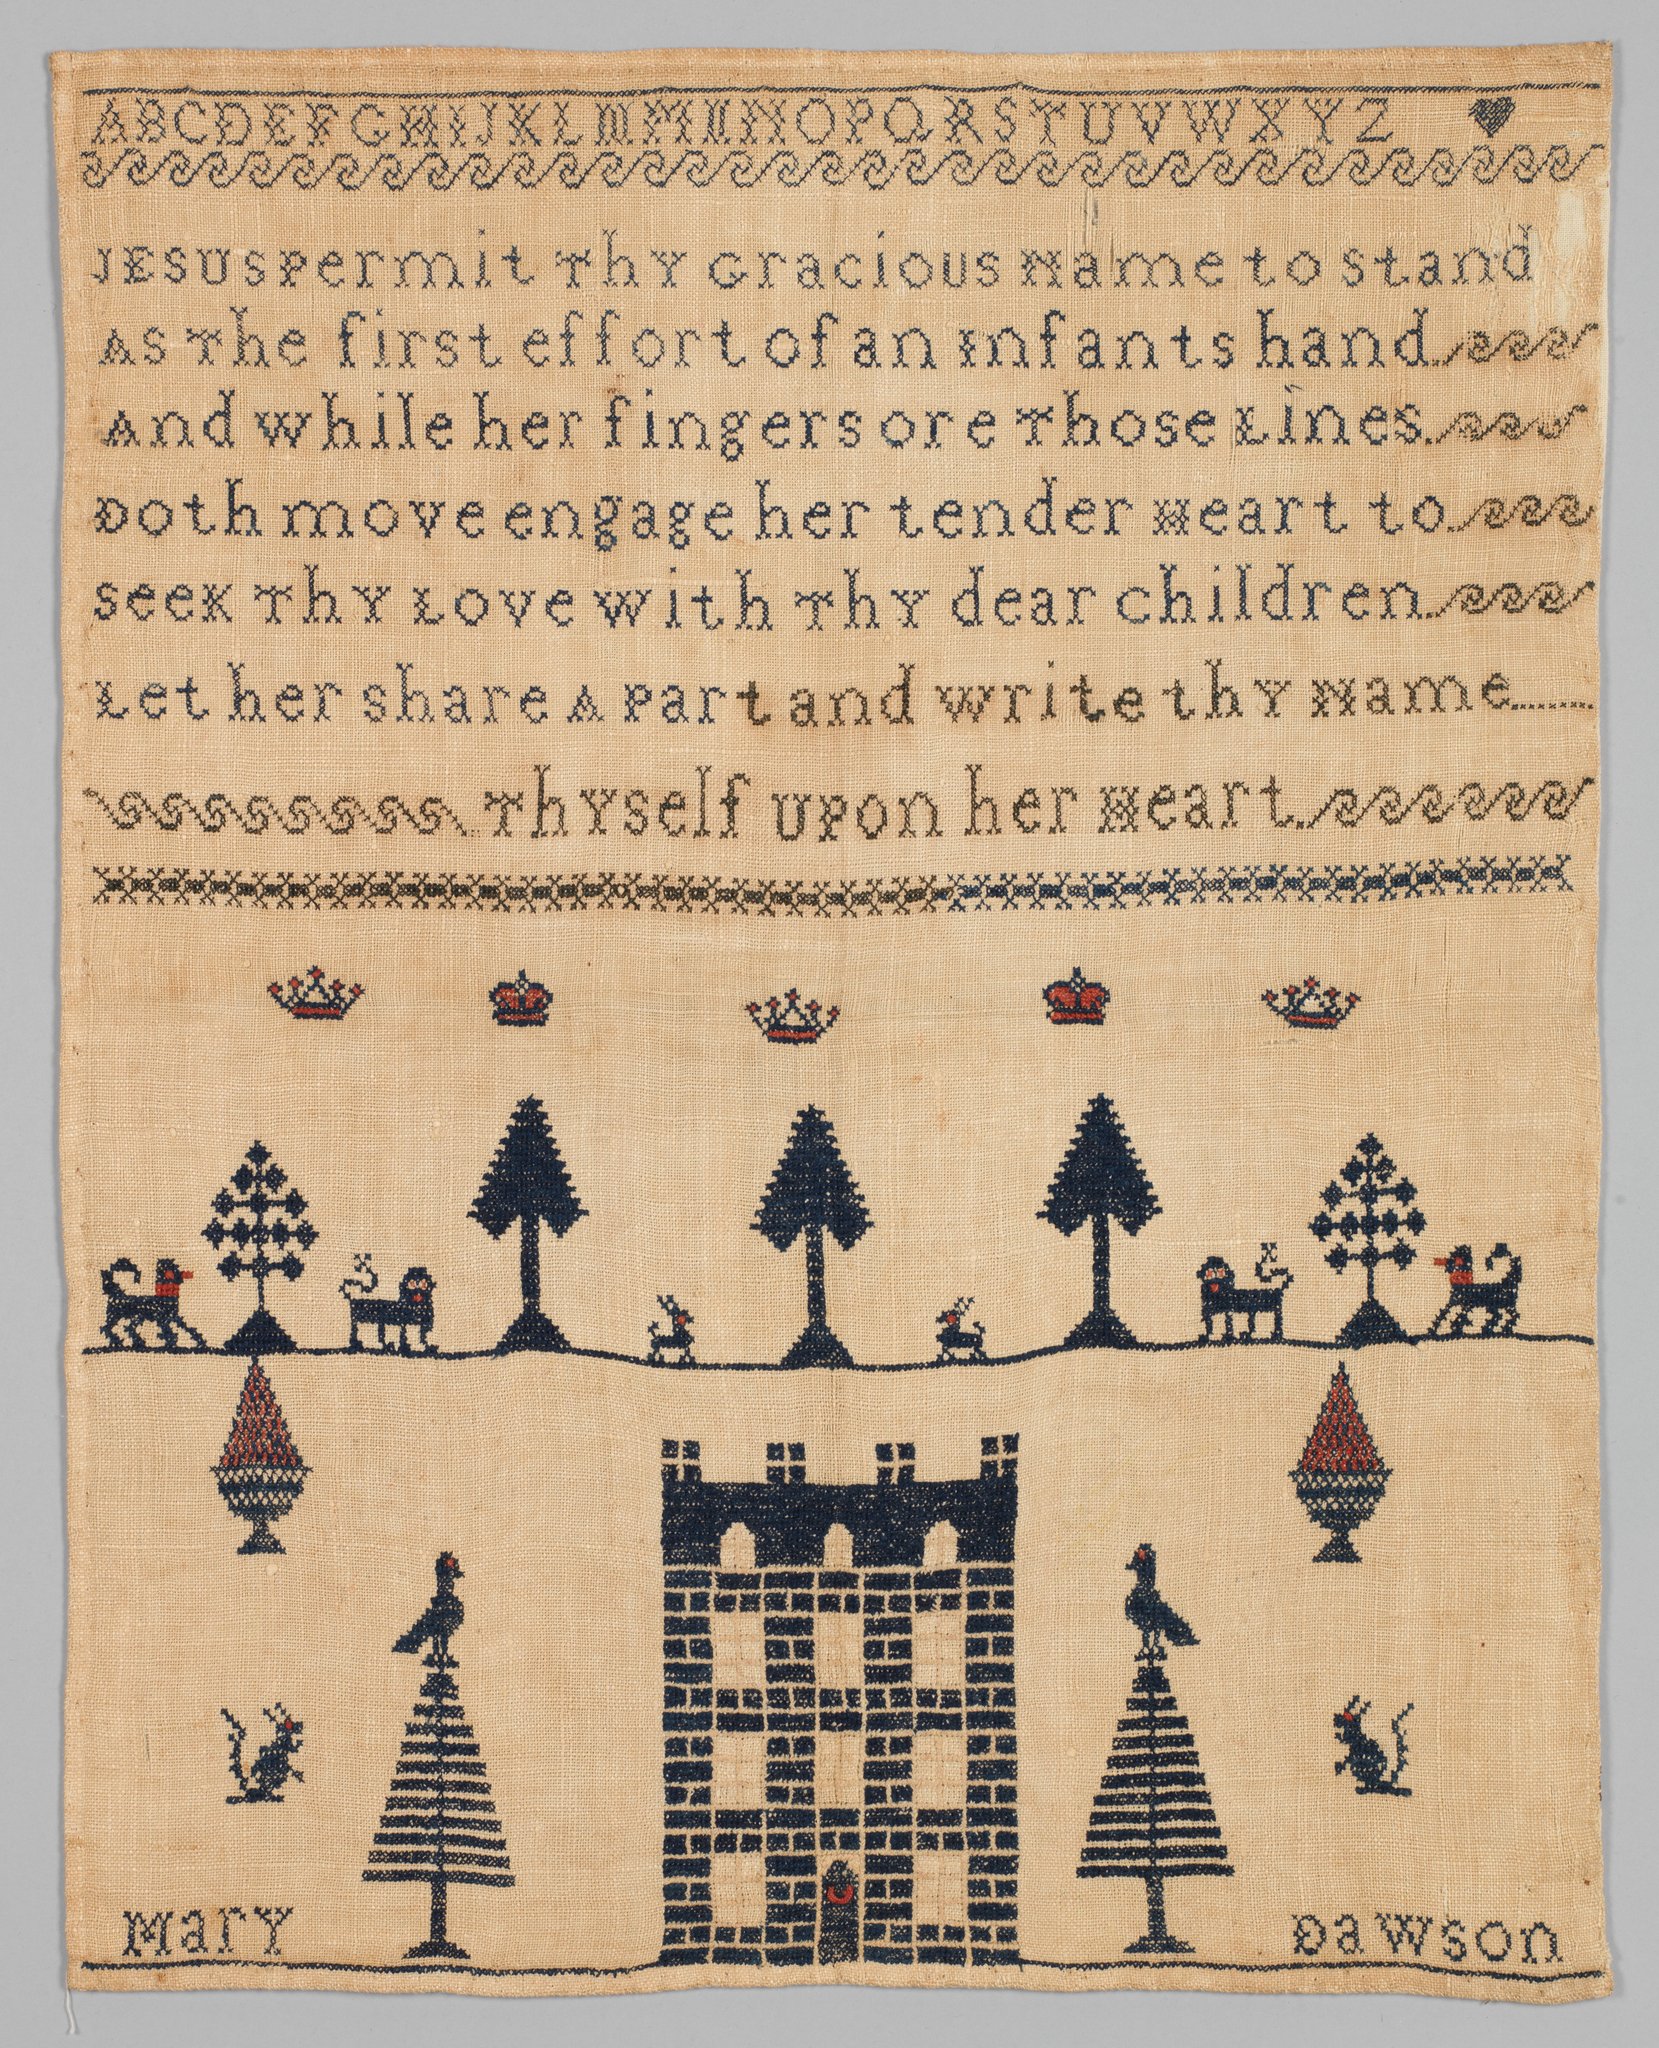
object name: sampler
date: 1701-1800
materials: cotton, linen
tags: birds,deer,dogs,lions,trees,crowns